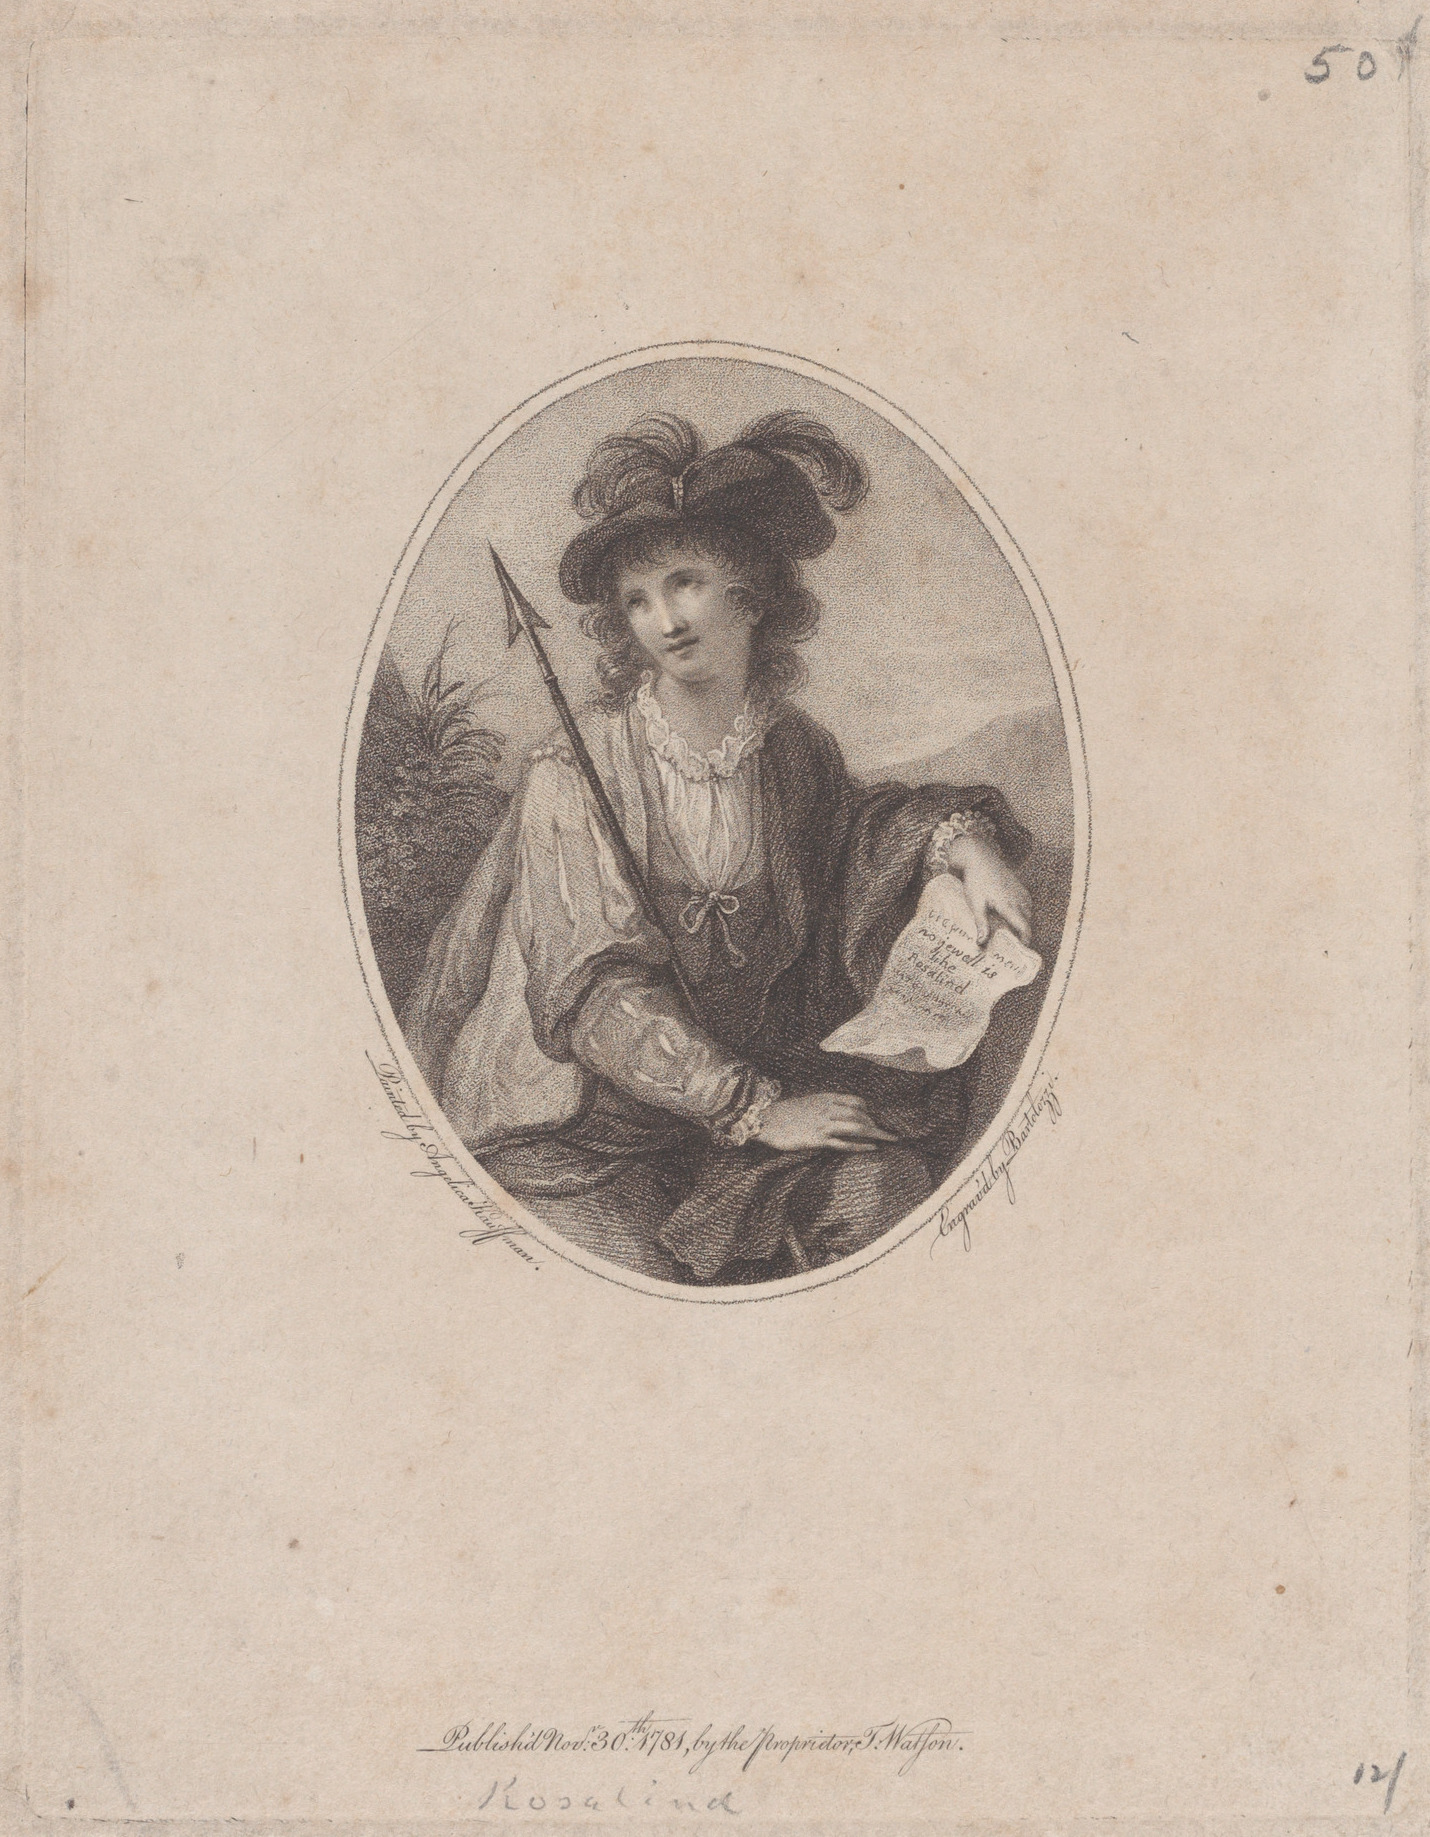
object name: print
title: Rosalind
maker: francesco bartolozzi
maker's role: artist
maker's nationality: italian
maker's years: 1728-1815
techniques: etching, engraving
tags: shakespeare,women